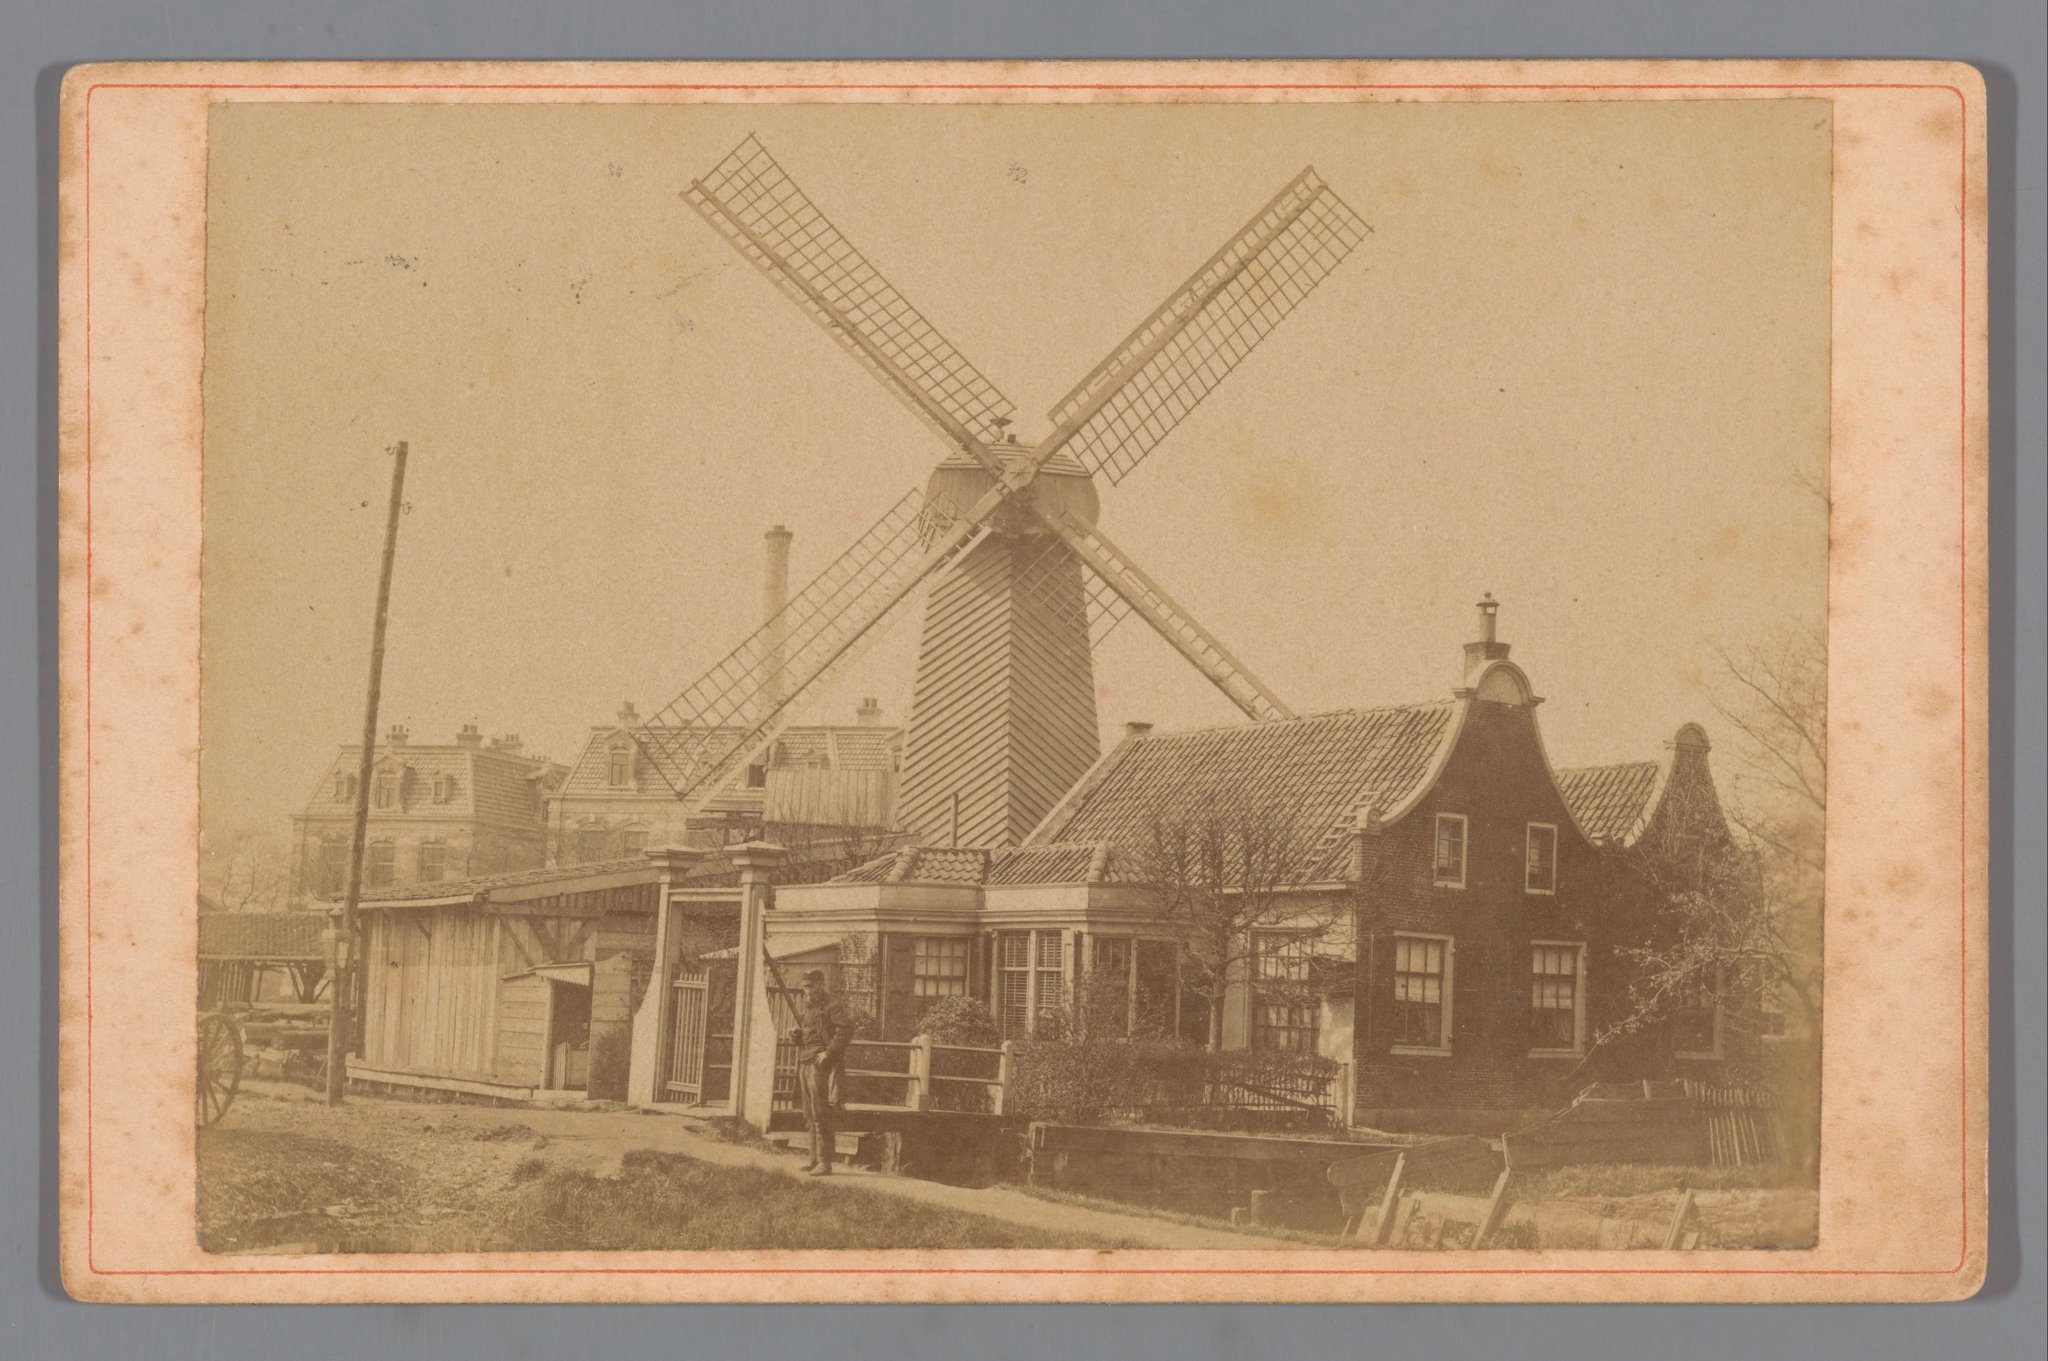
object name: photograph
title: Gezicht op Molen de Haan aan de Buitensingel in Amsterdam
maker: andreas theodorus rooswinkel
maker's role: fotograaf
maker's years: 1838-1909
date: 1881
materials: cardboard, photographic support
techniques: albumen print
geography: amsterdam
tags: windmill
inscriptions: annotation: ‘Molen de Haan "bij de theetuin "Keizerskroon"/ voormalige Buitensingel’, annotation: ‘Molen "de haan" Keizerskroon’, retailer's mark: ‘GEBR. DOUWES./ ATELIER/ Grimburgwal 15/ AMSTERDAM.’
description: Molen de Eendracht aan de voormalige Vijfhoekweg in Amsterdam. afgebroken in 1882.